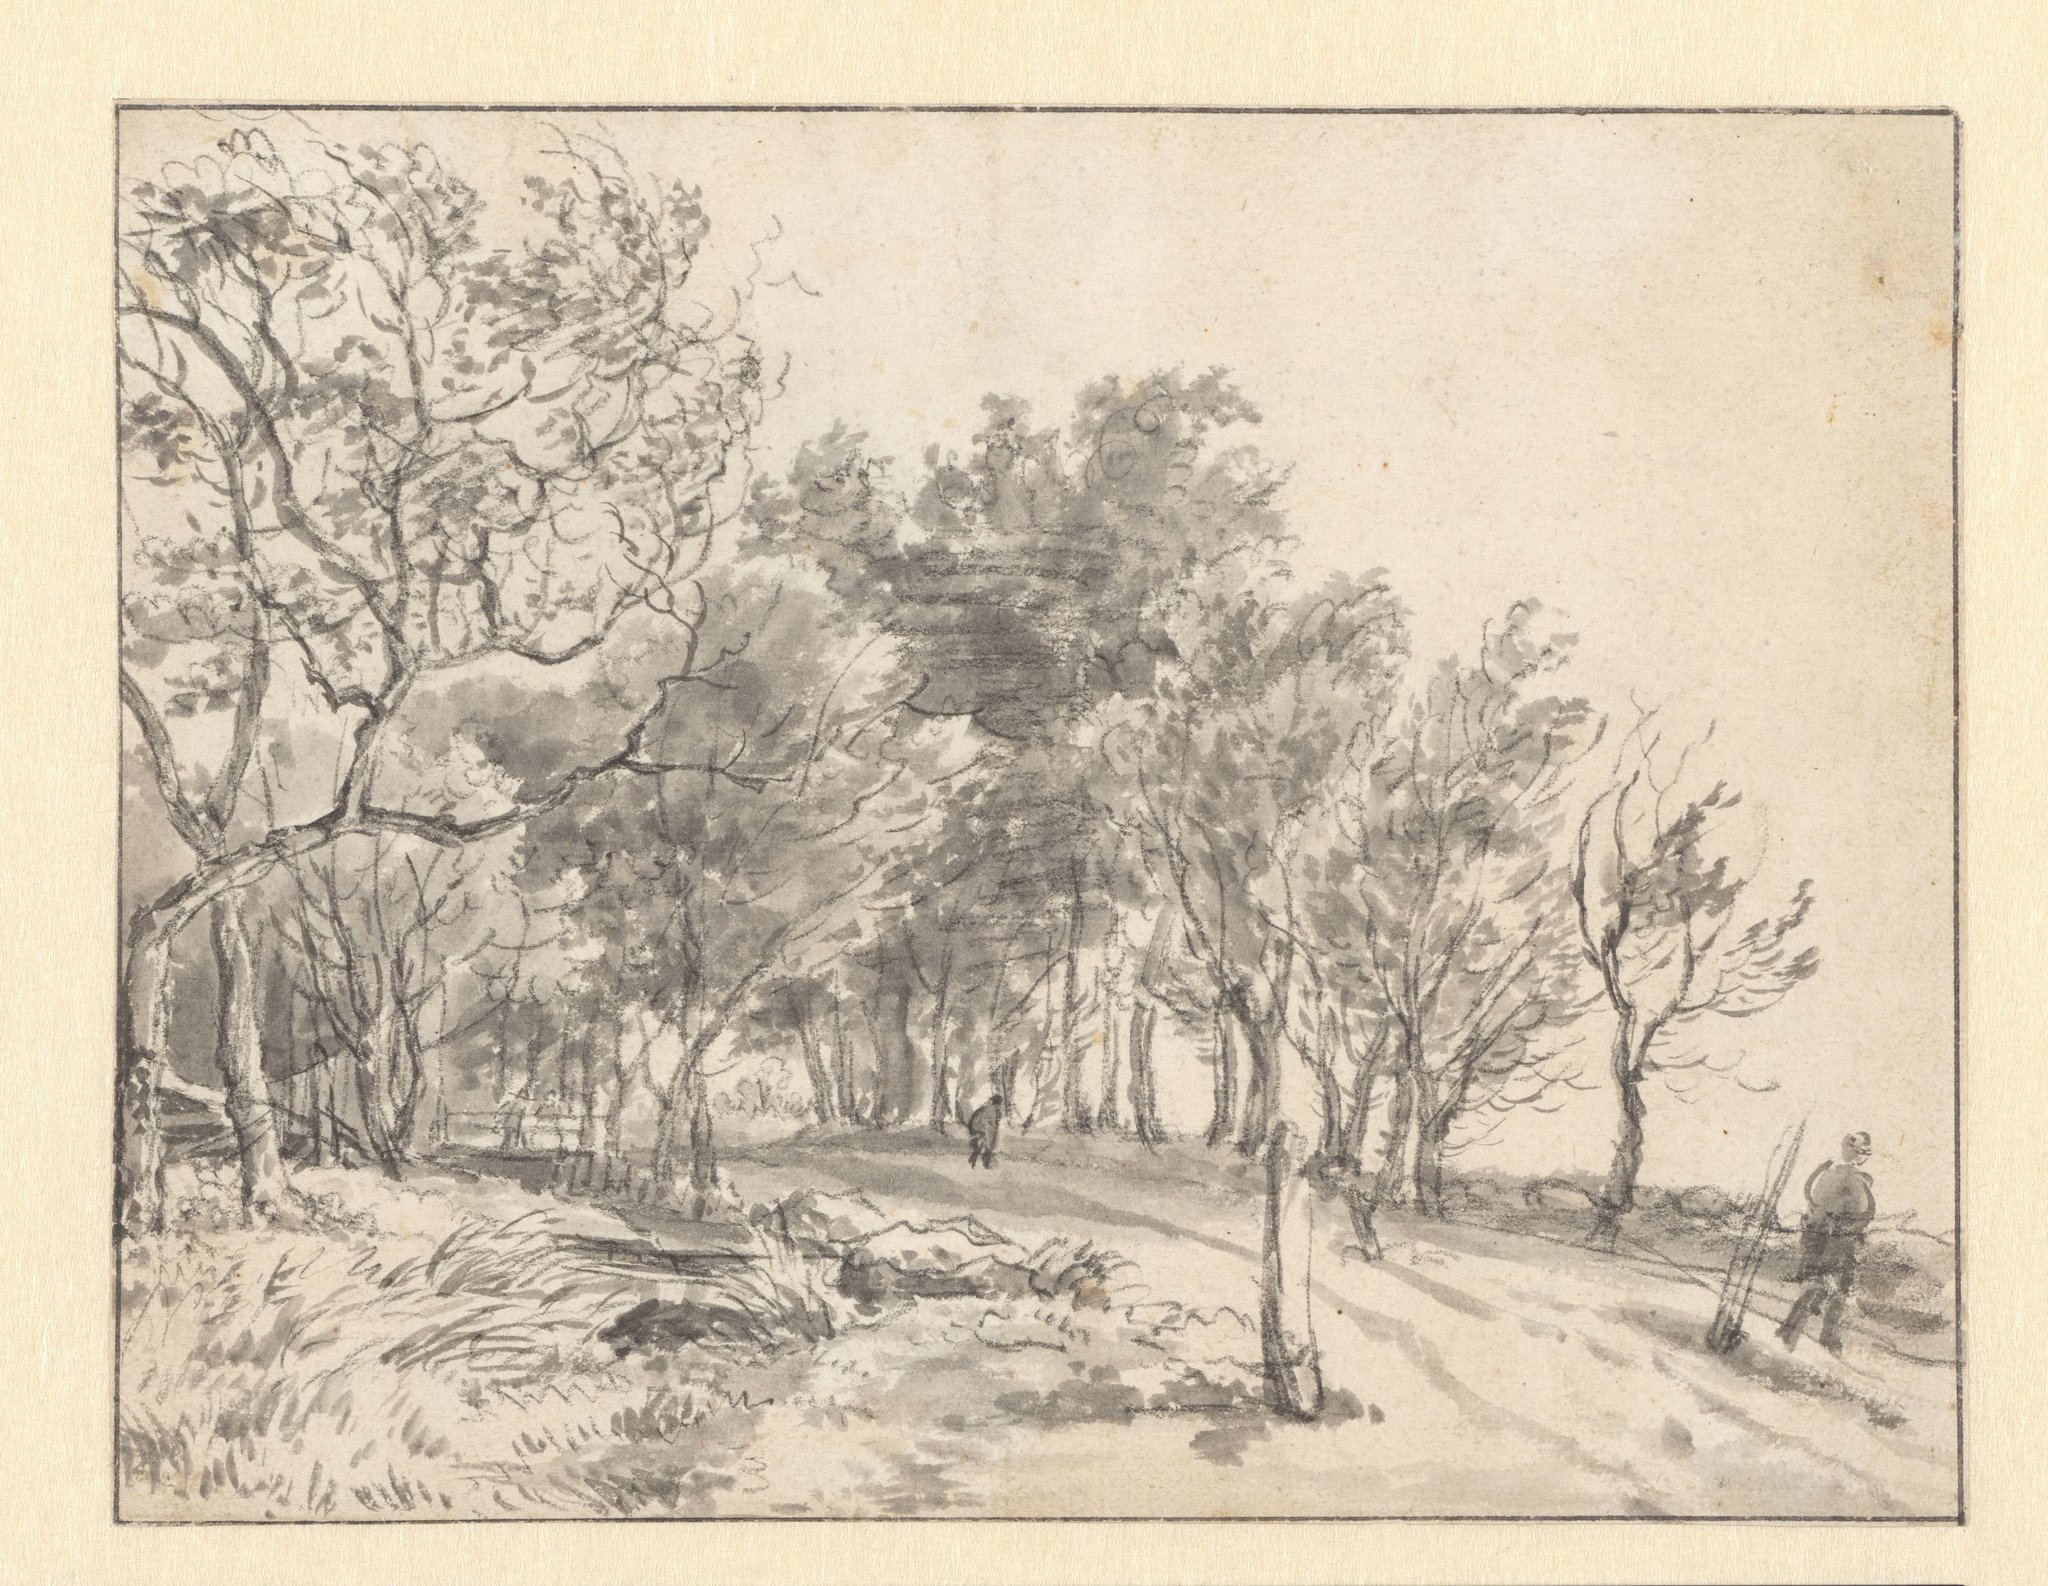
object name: drawing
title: Road through a Wooded Landscape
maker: jan van kessel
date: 1665-1680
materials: chalk, paper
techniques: brush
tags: forest, wood